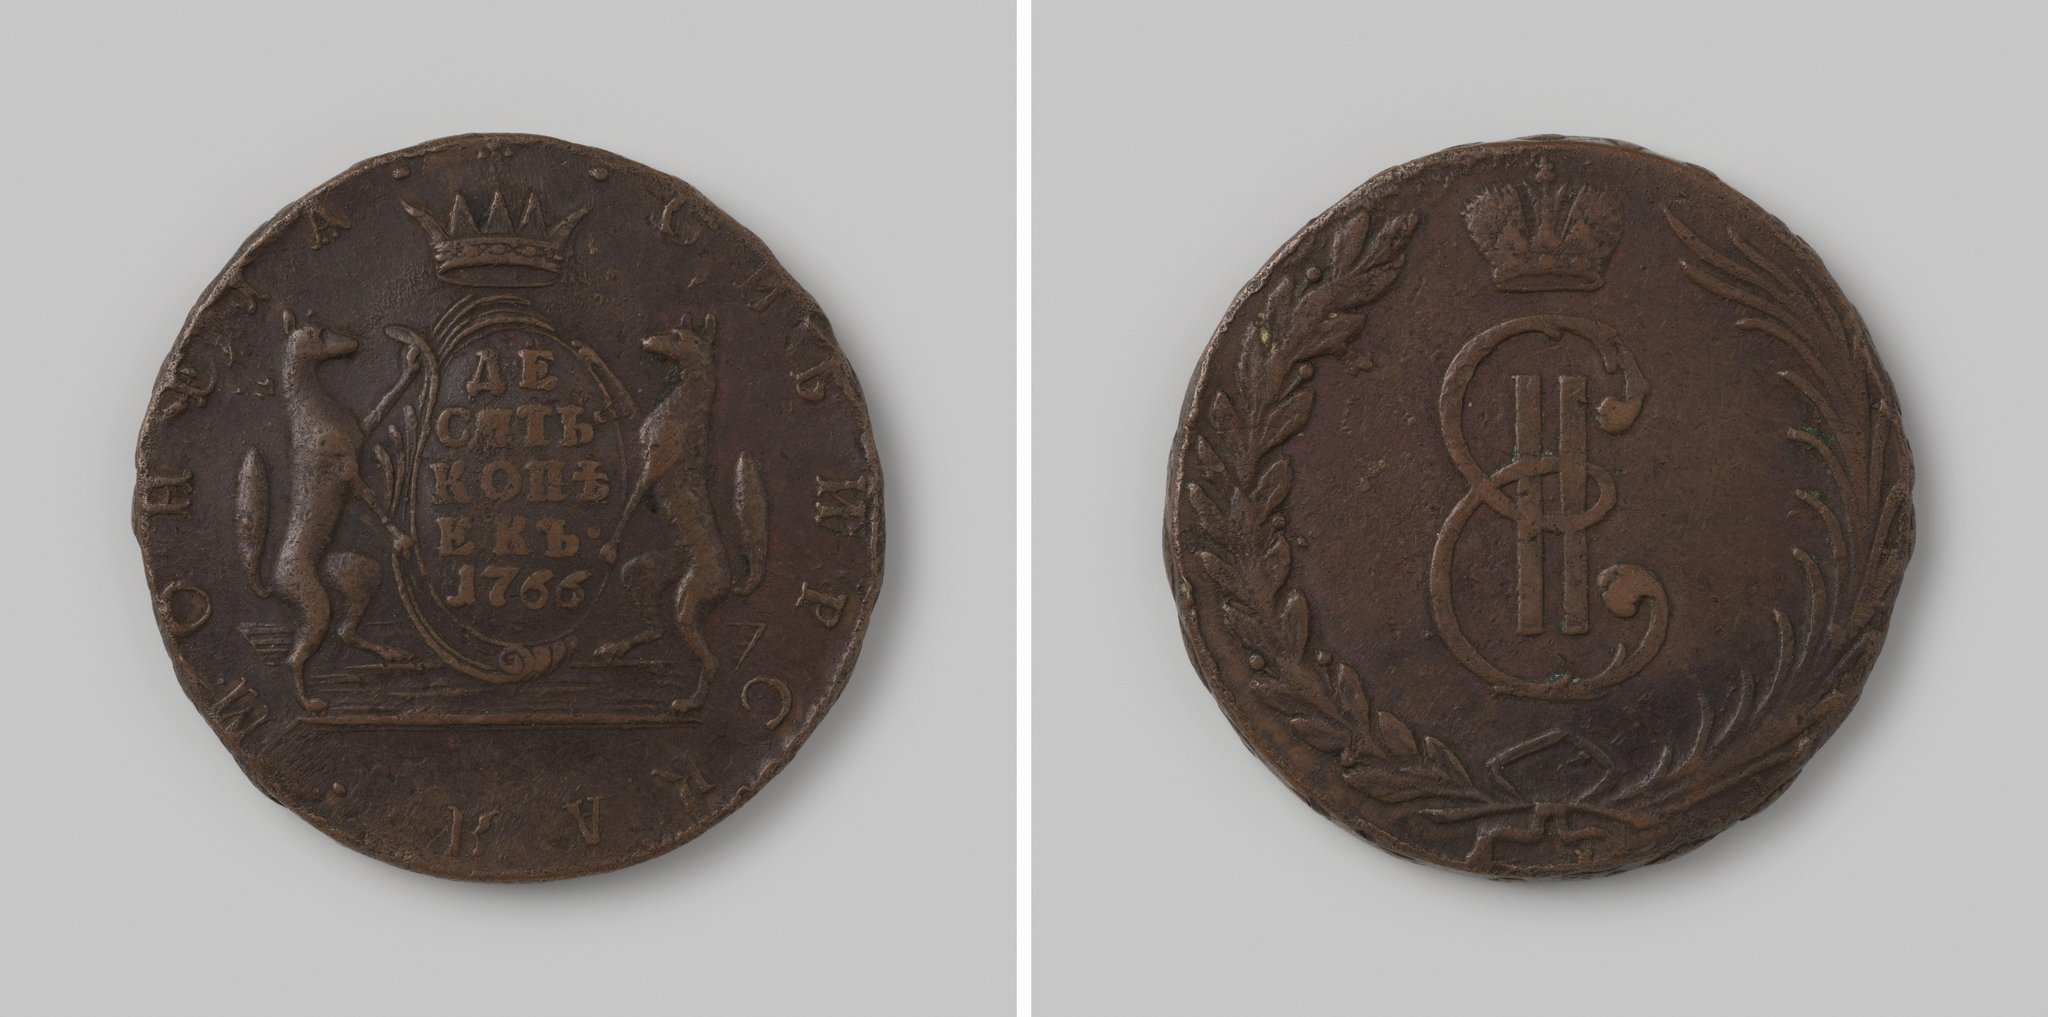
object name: coin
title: iberië als deel van Rusland, tsarina Catherina II, 10 kopeken, 1766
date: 1766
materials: copper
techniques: striking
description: Koperen munt. Voorzijde: door twee vossen als schildhouders gehouden geroond versierd wapenschild, waarin vieerregelige tekst in Cyrillische letters, waaronder jaartal. Keerzijde: tussen twee samengebonden takken het gekroonde monogram van Ekaterinma II. Randschrift. Geslagen in Kolyvan, Siberië.